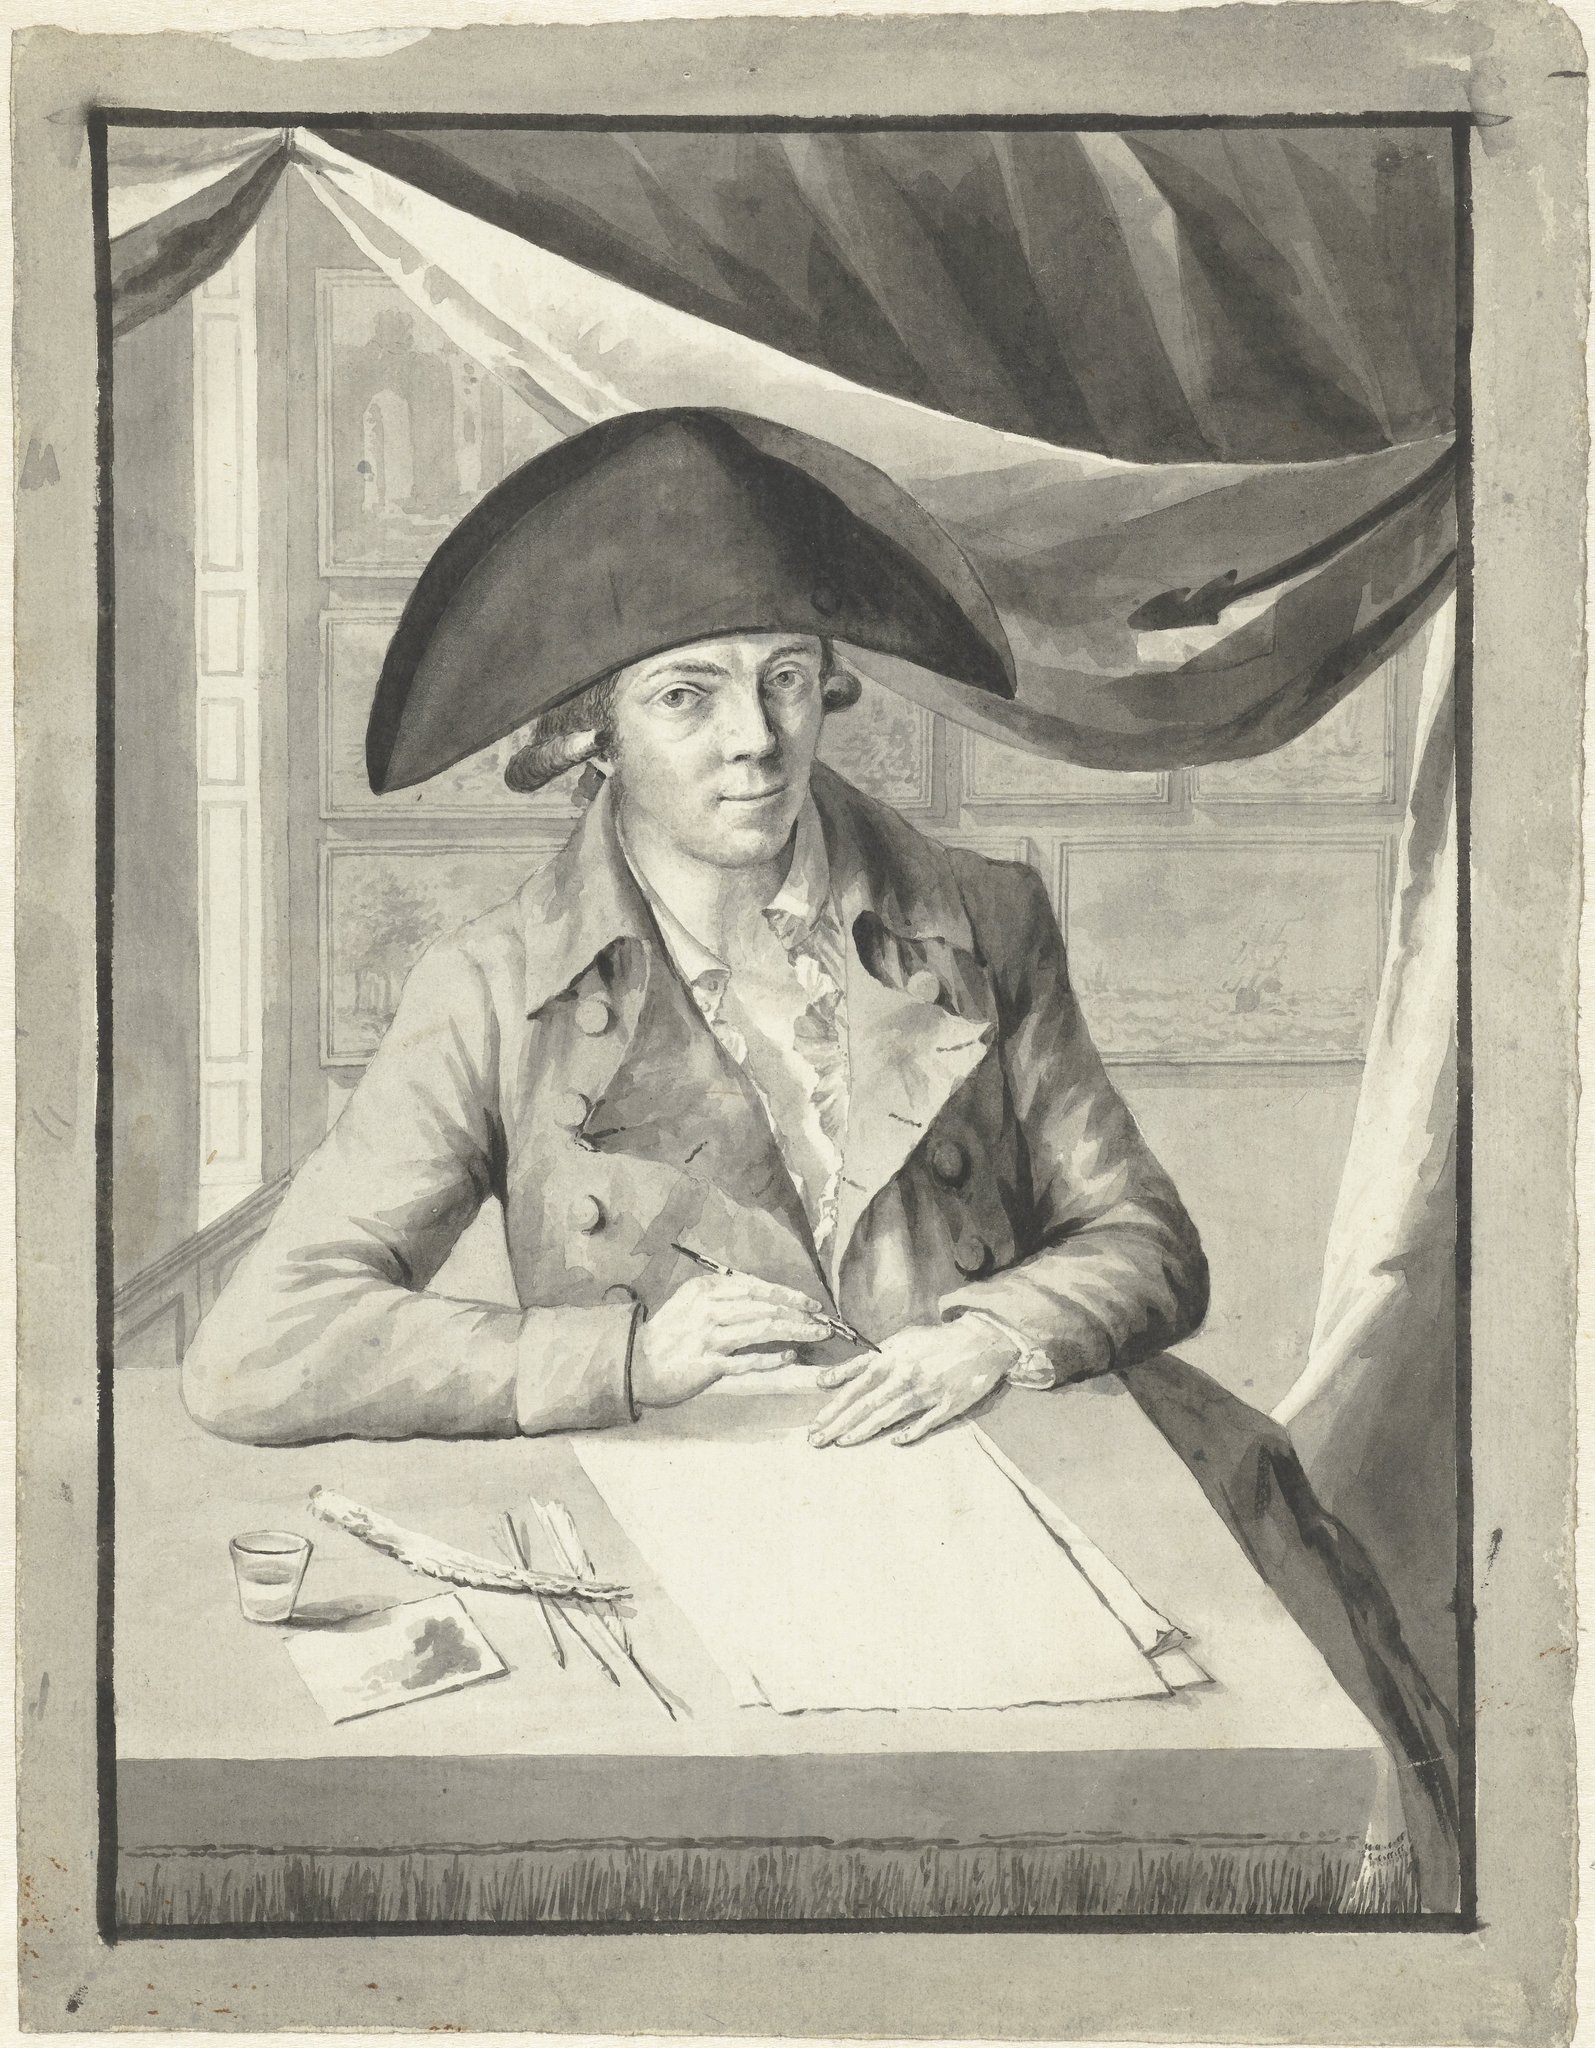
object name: drawing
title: Zelfportret van Hendrik Kuipers, zittend achter een tafel, tekenend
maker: hendrik kuipers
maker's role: print maker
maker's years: 1764-1798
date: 1790-1800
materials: graphite, paper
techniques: brush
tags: dordrecht, print maker, hendrik kuipers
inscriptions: date: ‘Anno 1797’, signature and date: ‘H. Kuipers’